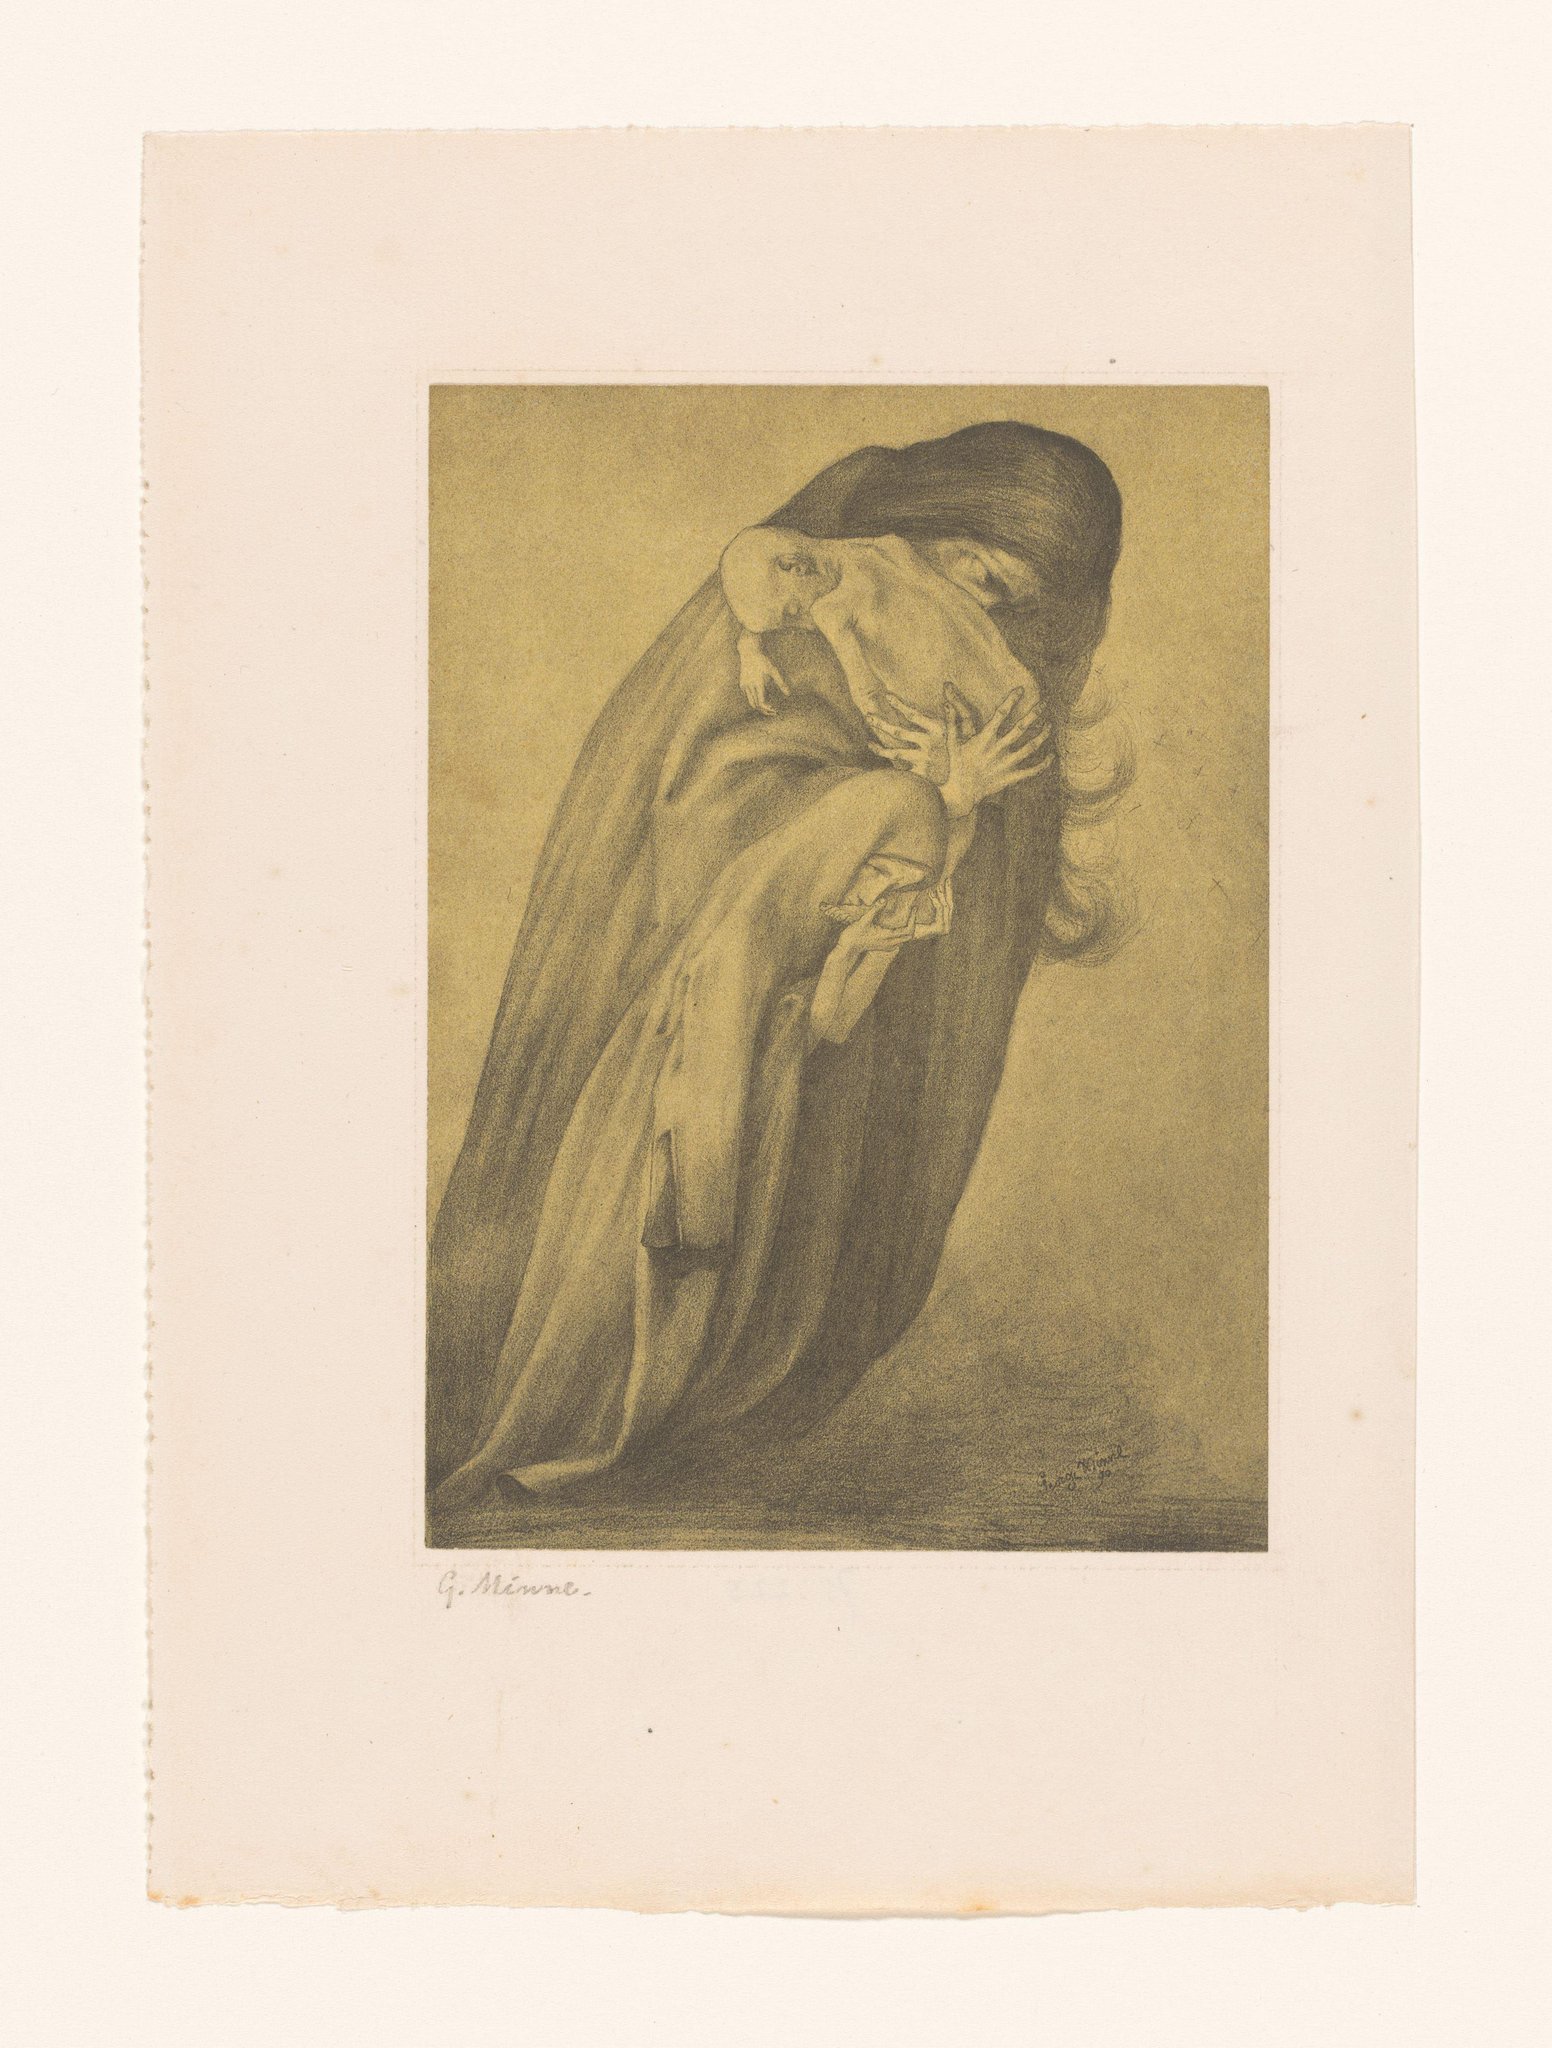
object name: print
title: Twee vrouwen met een dood kind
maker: Anonymous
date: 1898-1903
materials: paper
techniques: lithograph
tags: mother and baby or young child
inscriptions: collector's mark: Lugt 2228, collector's mark: Lugt 2760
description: Deze prent is gemaakt naar een tekening van George Minne uit 1890, nu in de collectie van het Museum voor Schone Kunsten Gent. De prent is waarschijnlijk verschenen in een editie van het het tijdschrift 'Ver Sacrum', dat werd uitgegeven tussen 1898 en 1903.